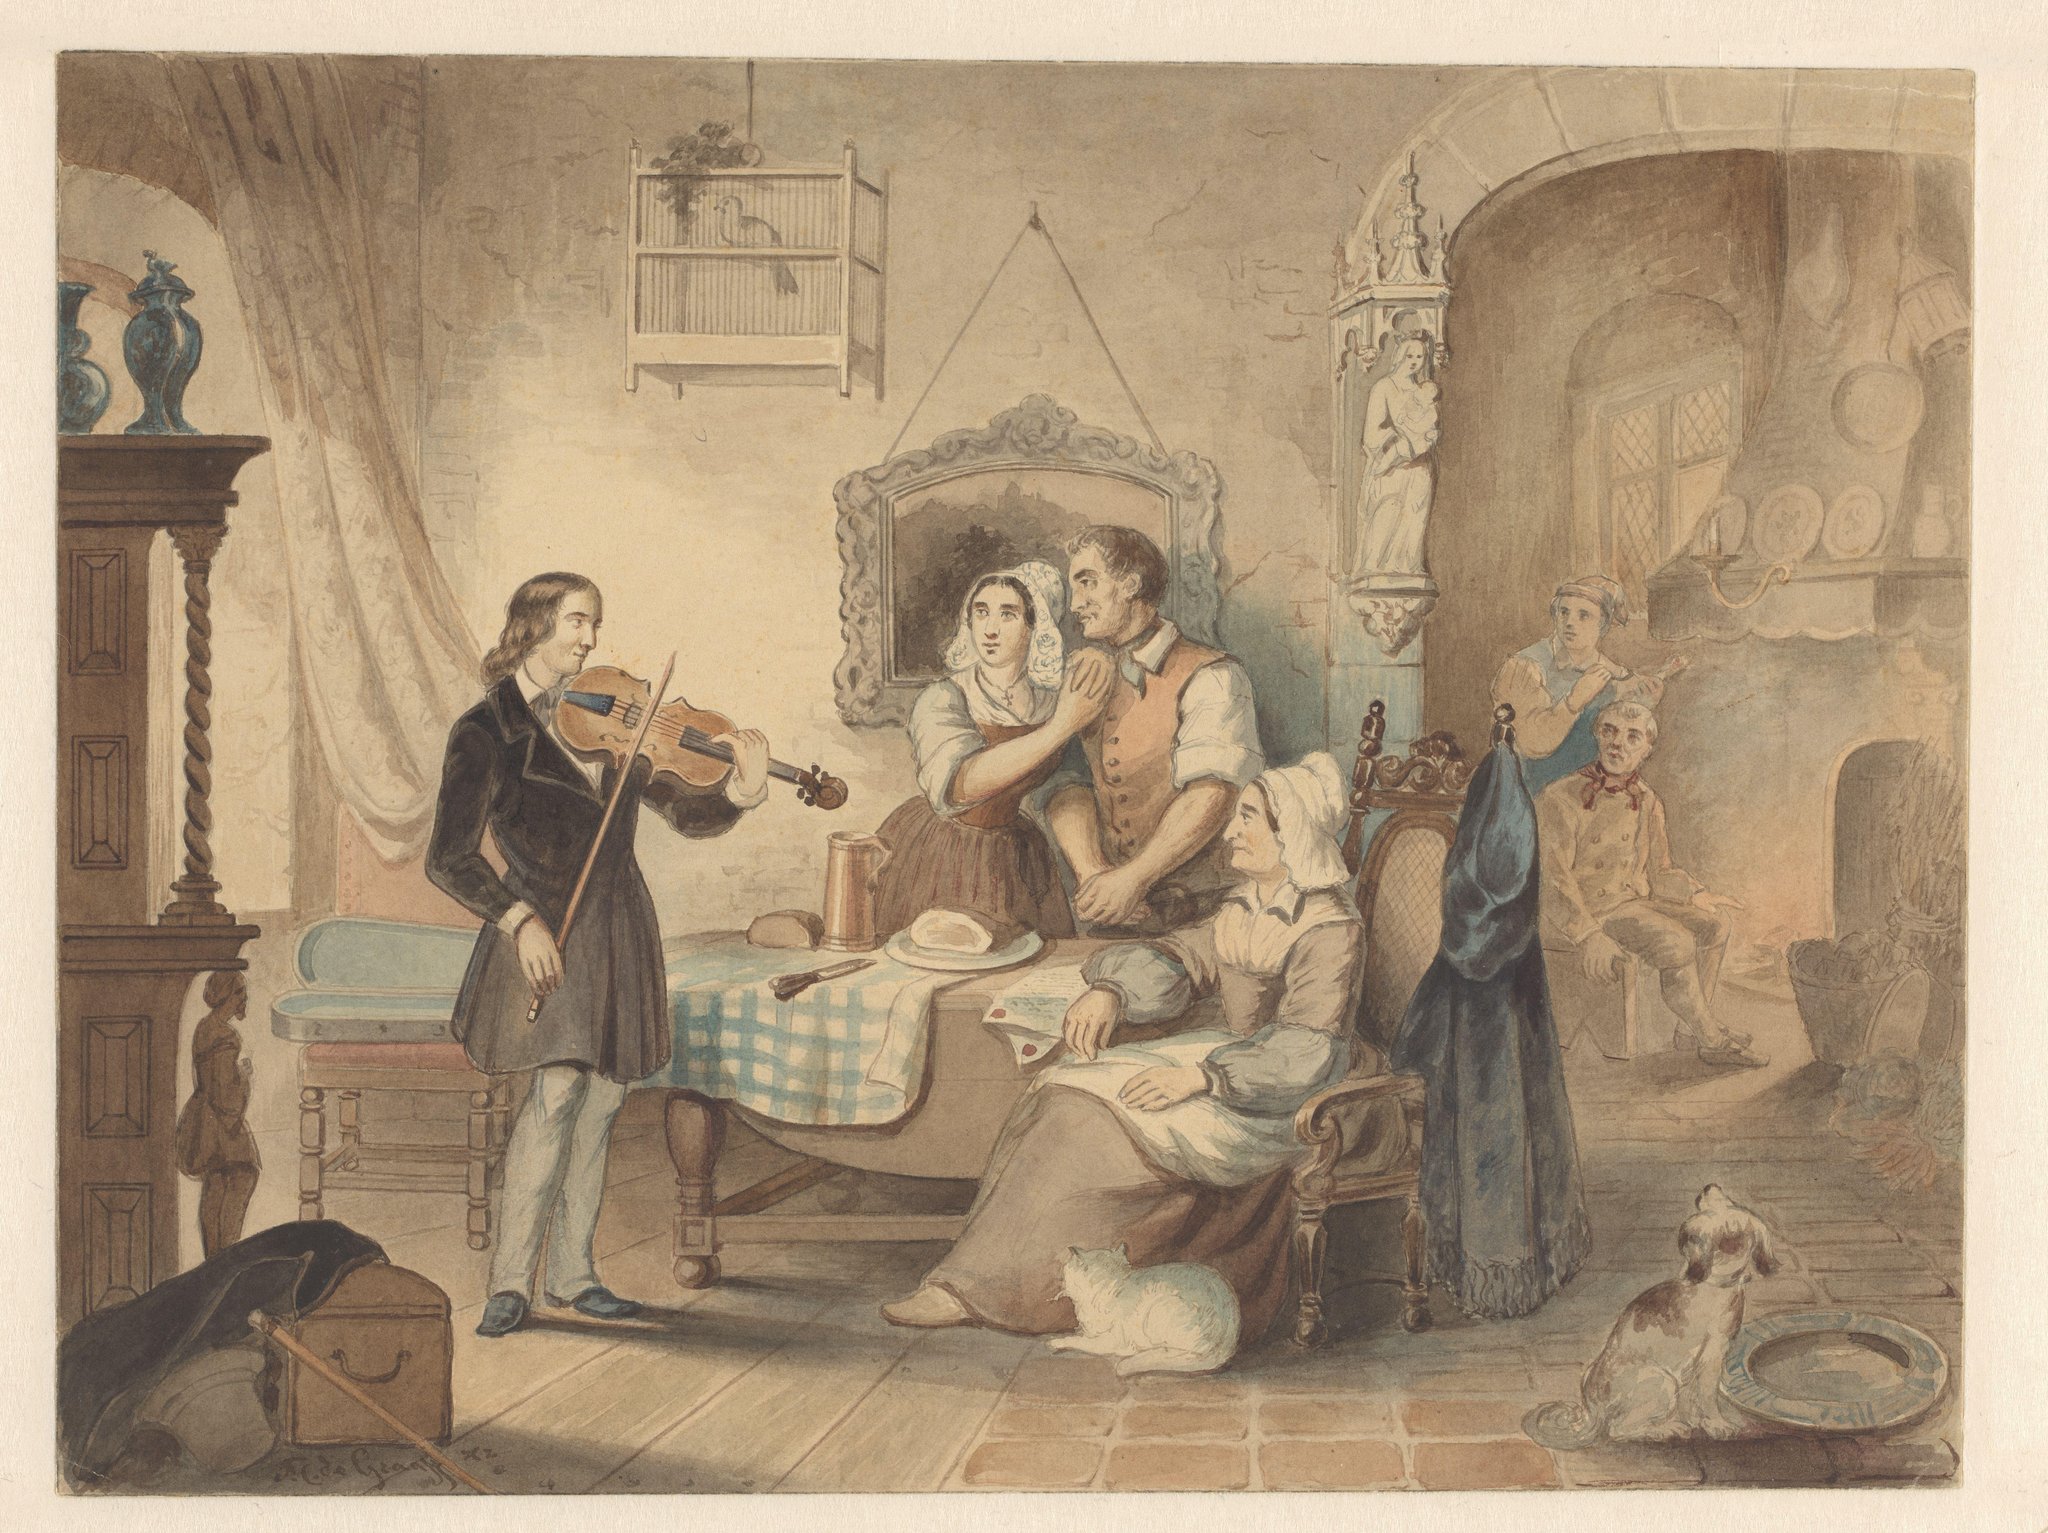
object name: drawing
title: Charles Auguste de Bériot speelt viool voor een gezelschap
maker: frederik carel de graaff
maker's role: draughtsman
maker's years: 1819-1897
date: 1829-1897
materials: ink, paper, pencil, watercolor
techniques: brush, pen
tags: brussels, one person playing string instrument (bowed), violin, fiddle, interior of the house, composer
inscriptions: inscription: ‘F.C. de Graag H Zn/ Berio zijne eerste compositie spelende’, collector's mark: Lugt 2228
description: Interieur met een gezelschap rond een tafel en doorkijk naar twee figuren bij een haard. De Bériot staat bij de tafel en speelt zijn compositie voor het luisterend publiek.